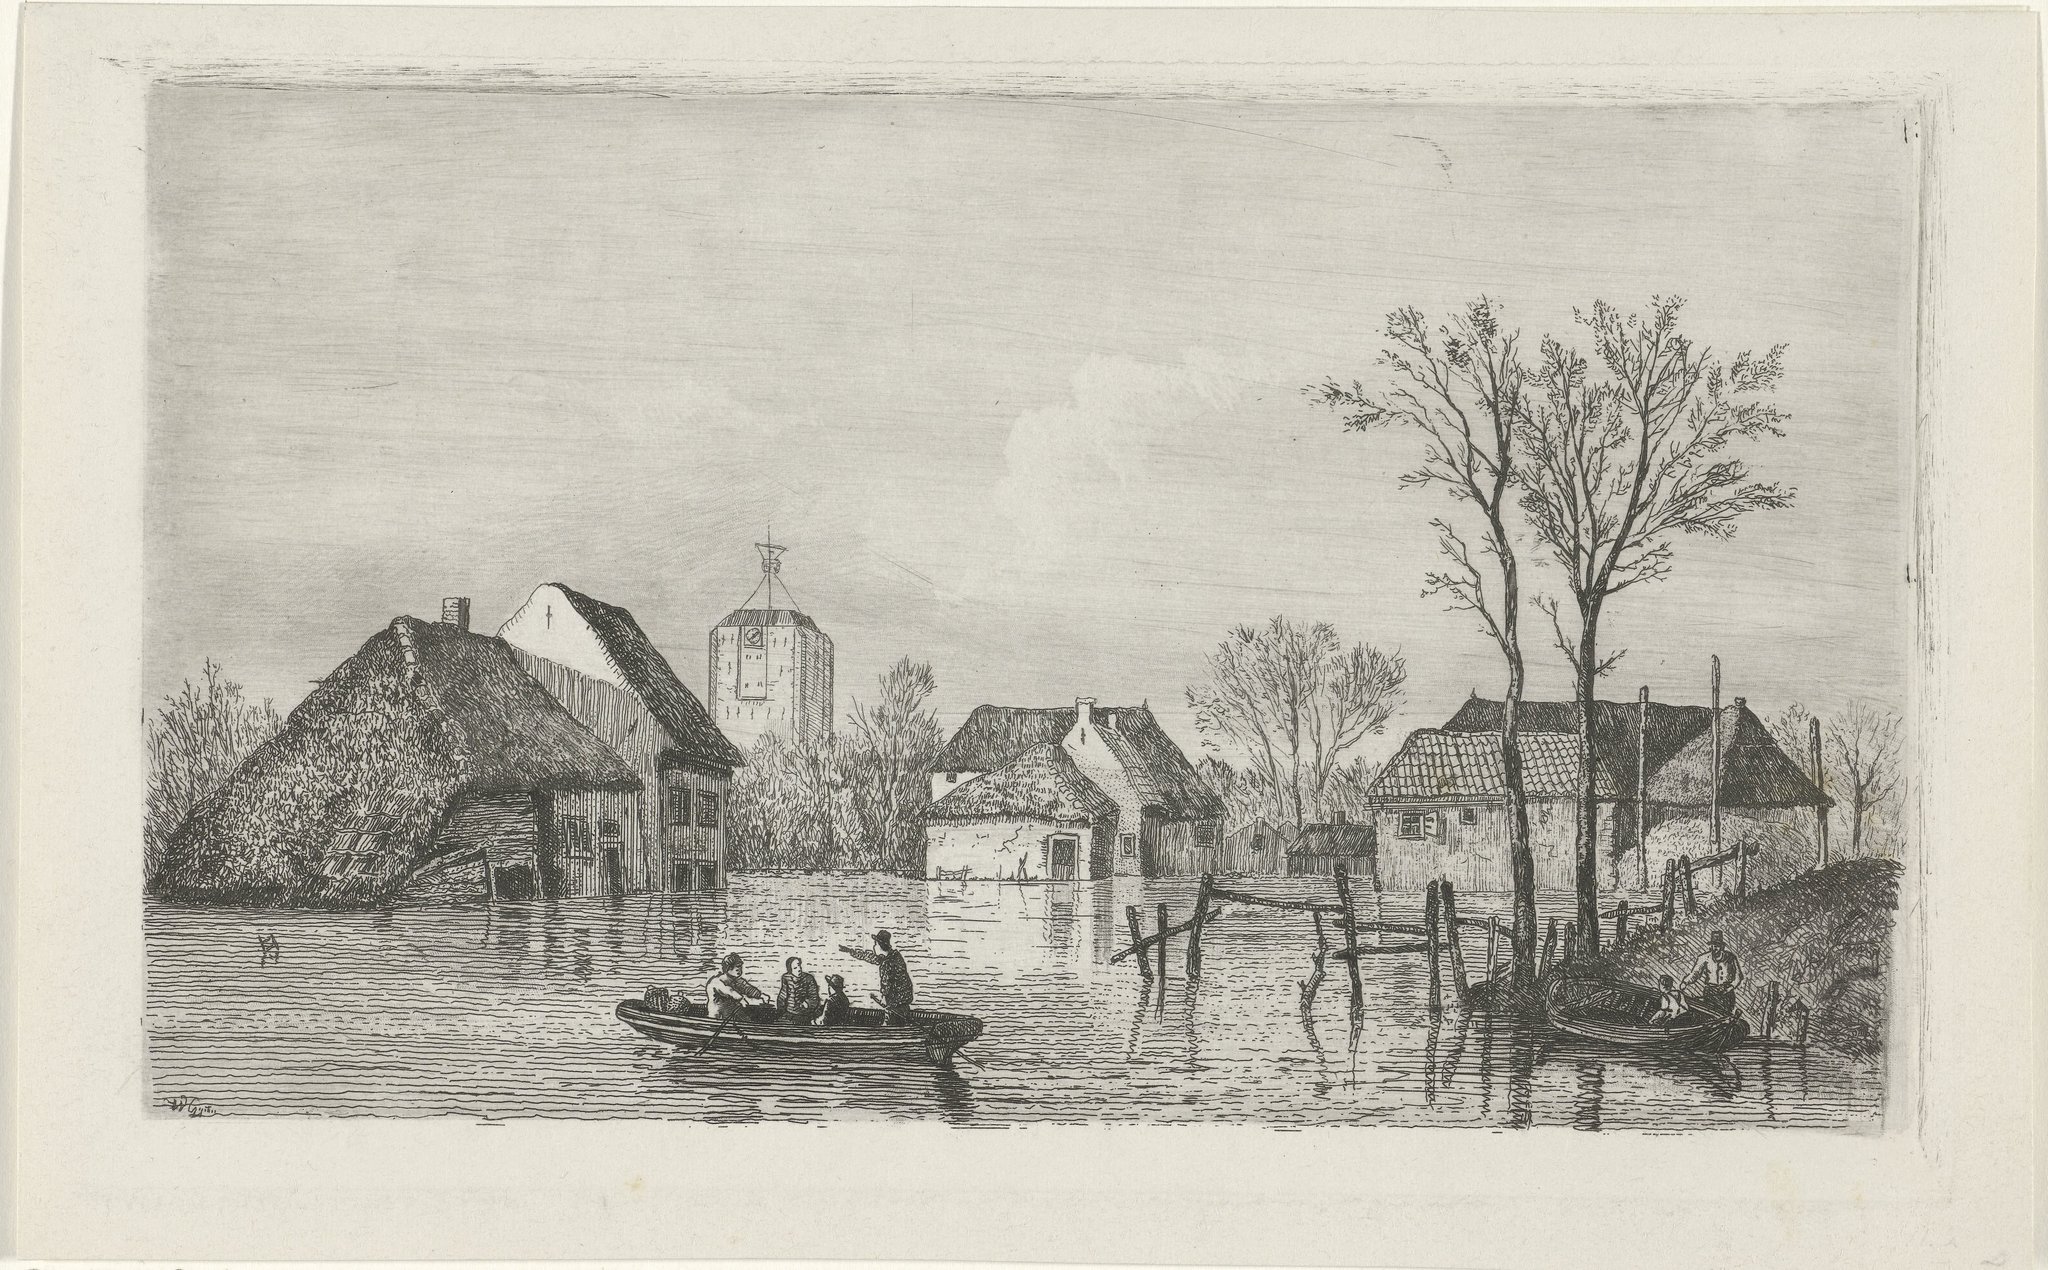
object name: print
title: Overstroming bij Beesd, 1855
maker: willem gruyter jr.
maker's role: draughtsman, print maker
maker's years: 1817-1880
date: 1832-1880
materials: paper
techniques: aquatint, drypoint, etching, roulette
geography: amsterdam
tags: flood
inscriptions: collector's mark: Lugt 2228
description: Landschap met overstroming bij Beesd in 1855. Op de achtergrond zijn ondergelopen boerderijen en de kerktoren van Beesd zichtbaar.